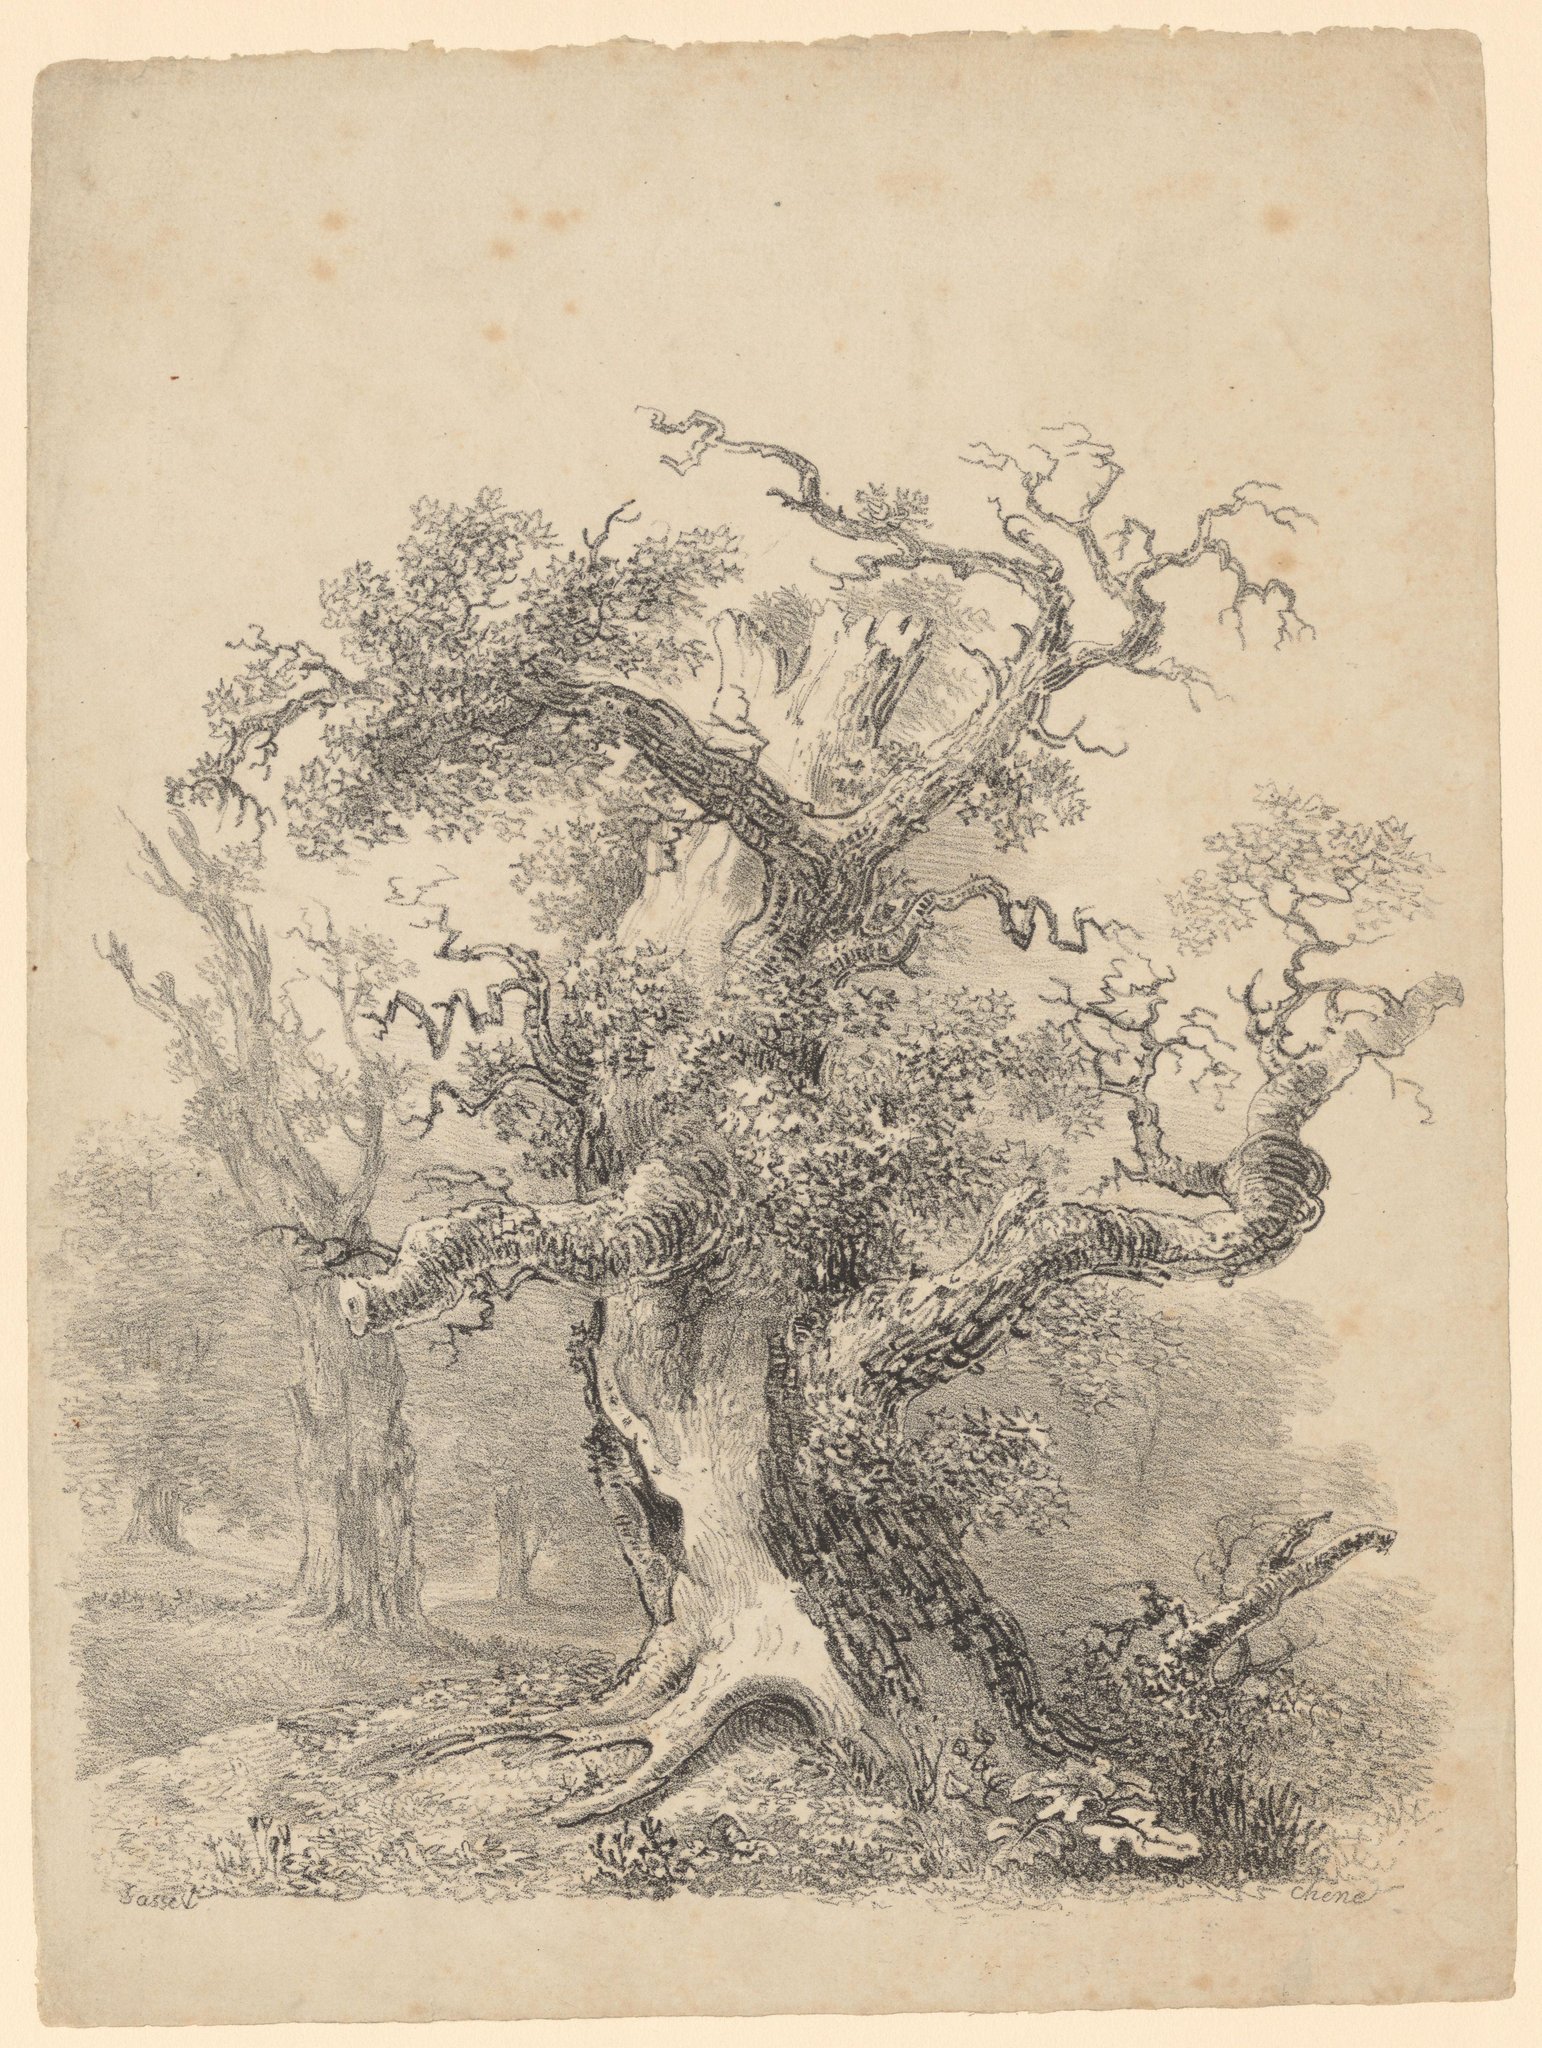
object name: print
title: Eikenboom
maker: richard sasse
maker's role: print maker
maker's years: 1774-1849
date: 1800-1849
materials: paper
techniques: lithograph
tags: trees: oak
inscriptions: collector's mark: Lugt 2760, collector's mark: Lugt 2228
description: Prent behoort mogelijk tot de serie 'L'art de dessiner le paysage d'apres nature'. Deze serie is in tien delen met elk zes lithografieën uitgegeven.